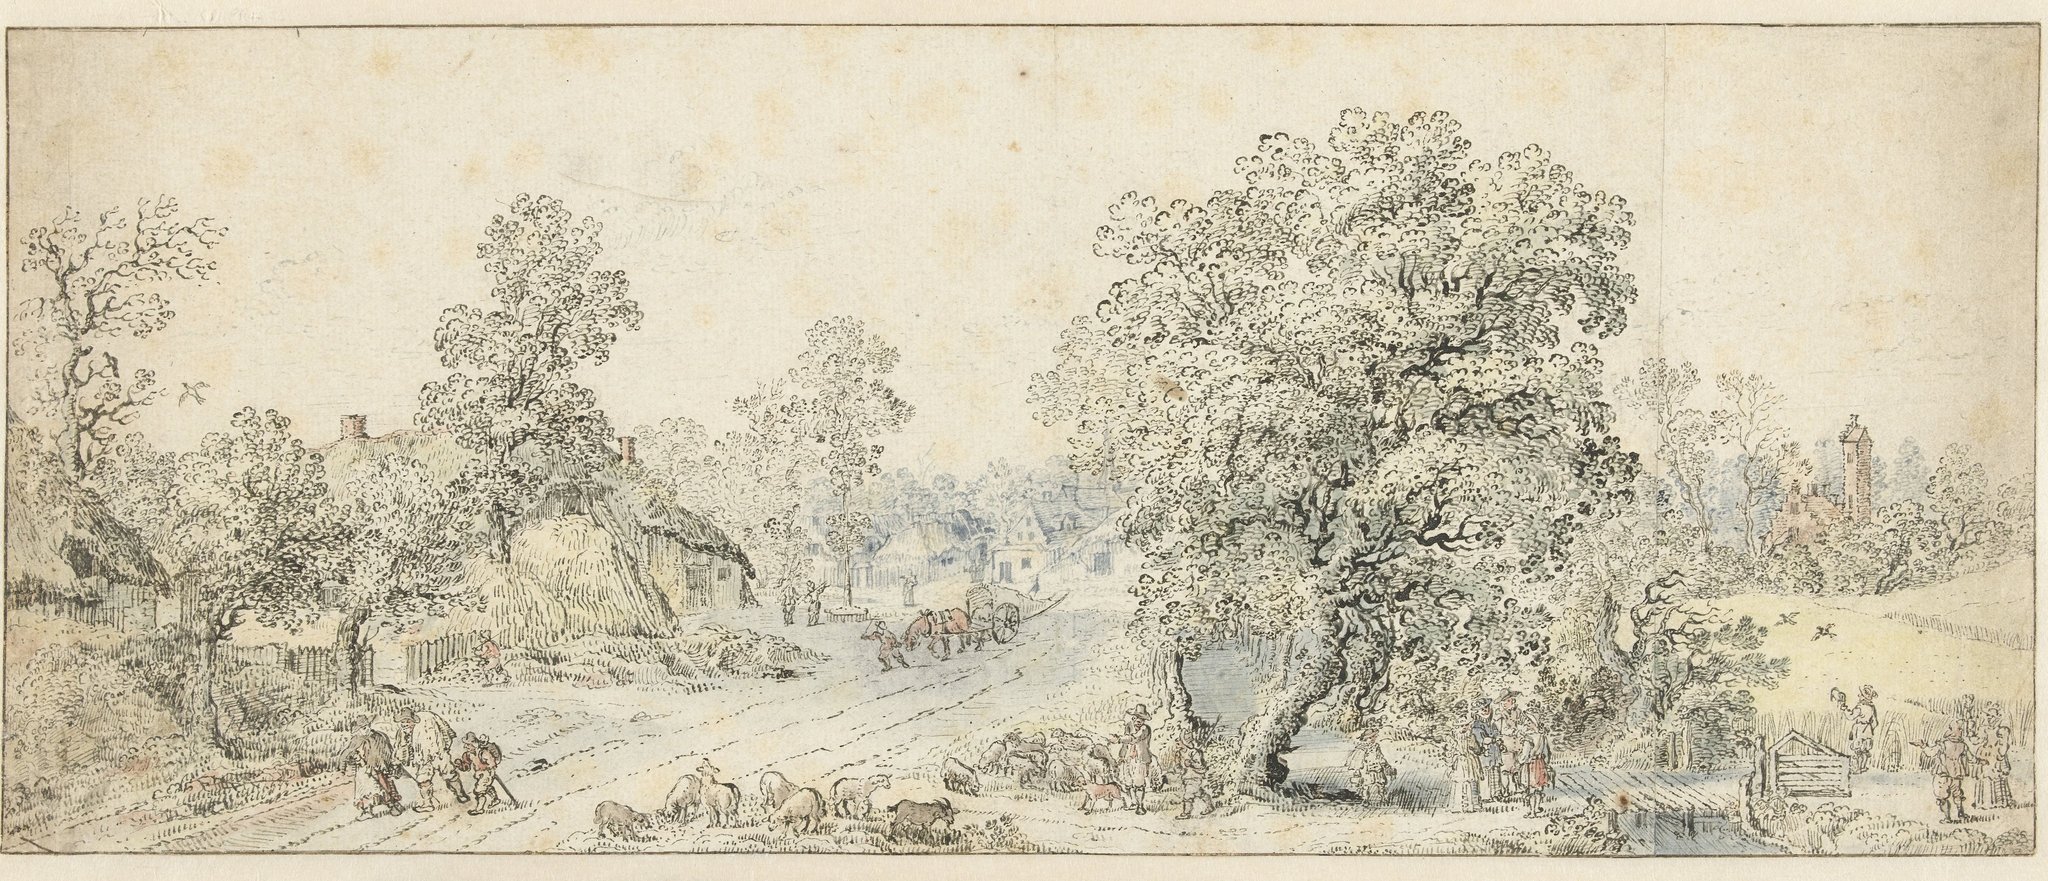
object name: drawing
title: Landschap met wandelaars, een herder en veel andere figuren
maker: Anonymous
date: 1600-1699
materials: ink, paper, watercolor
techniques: brush, pen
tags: prospect of village, silhouette of village, herd, flock